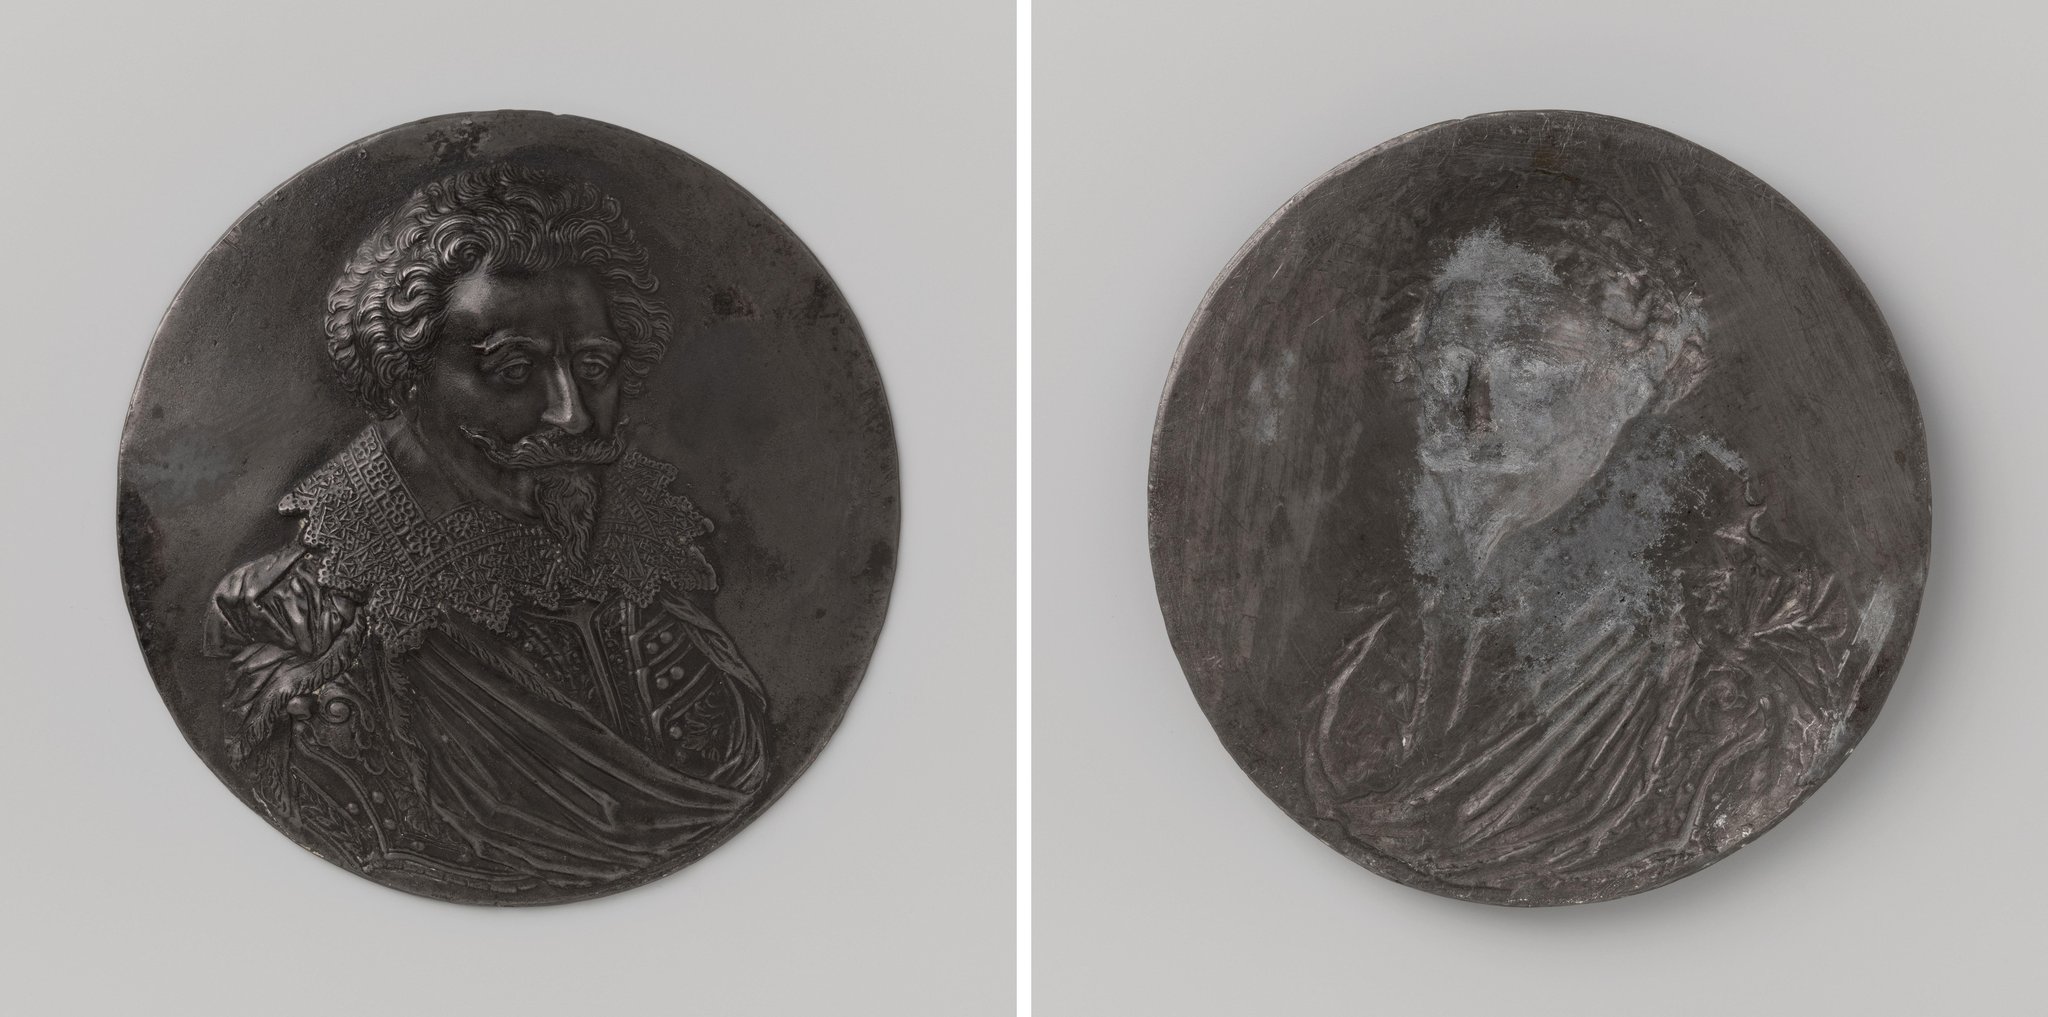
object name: plaque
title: Frederik Hendrik, prins van Oranje-Nassau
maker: johannes lutma (1584-1669)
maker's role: draughtsman, print maker, silversmith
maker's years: 1584-1669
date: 1626-1669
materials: lead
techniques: casting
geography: amsterdam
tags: the hague, frederick henry (prince of orange)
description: eenzijdige plaquette. Voorzijde: borststuk man. Keerzijde: blanco